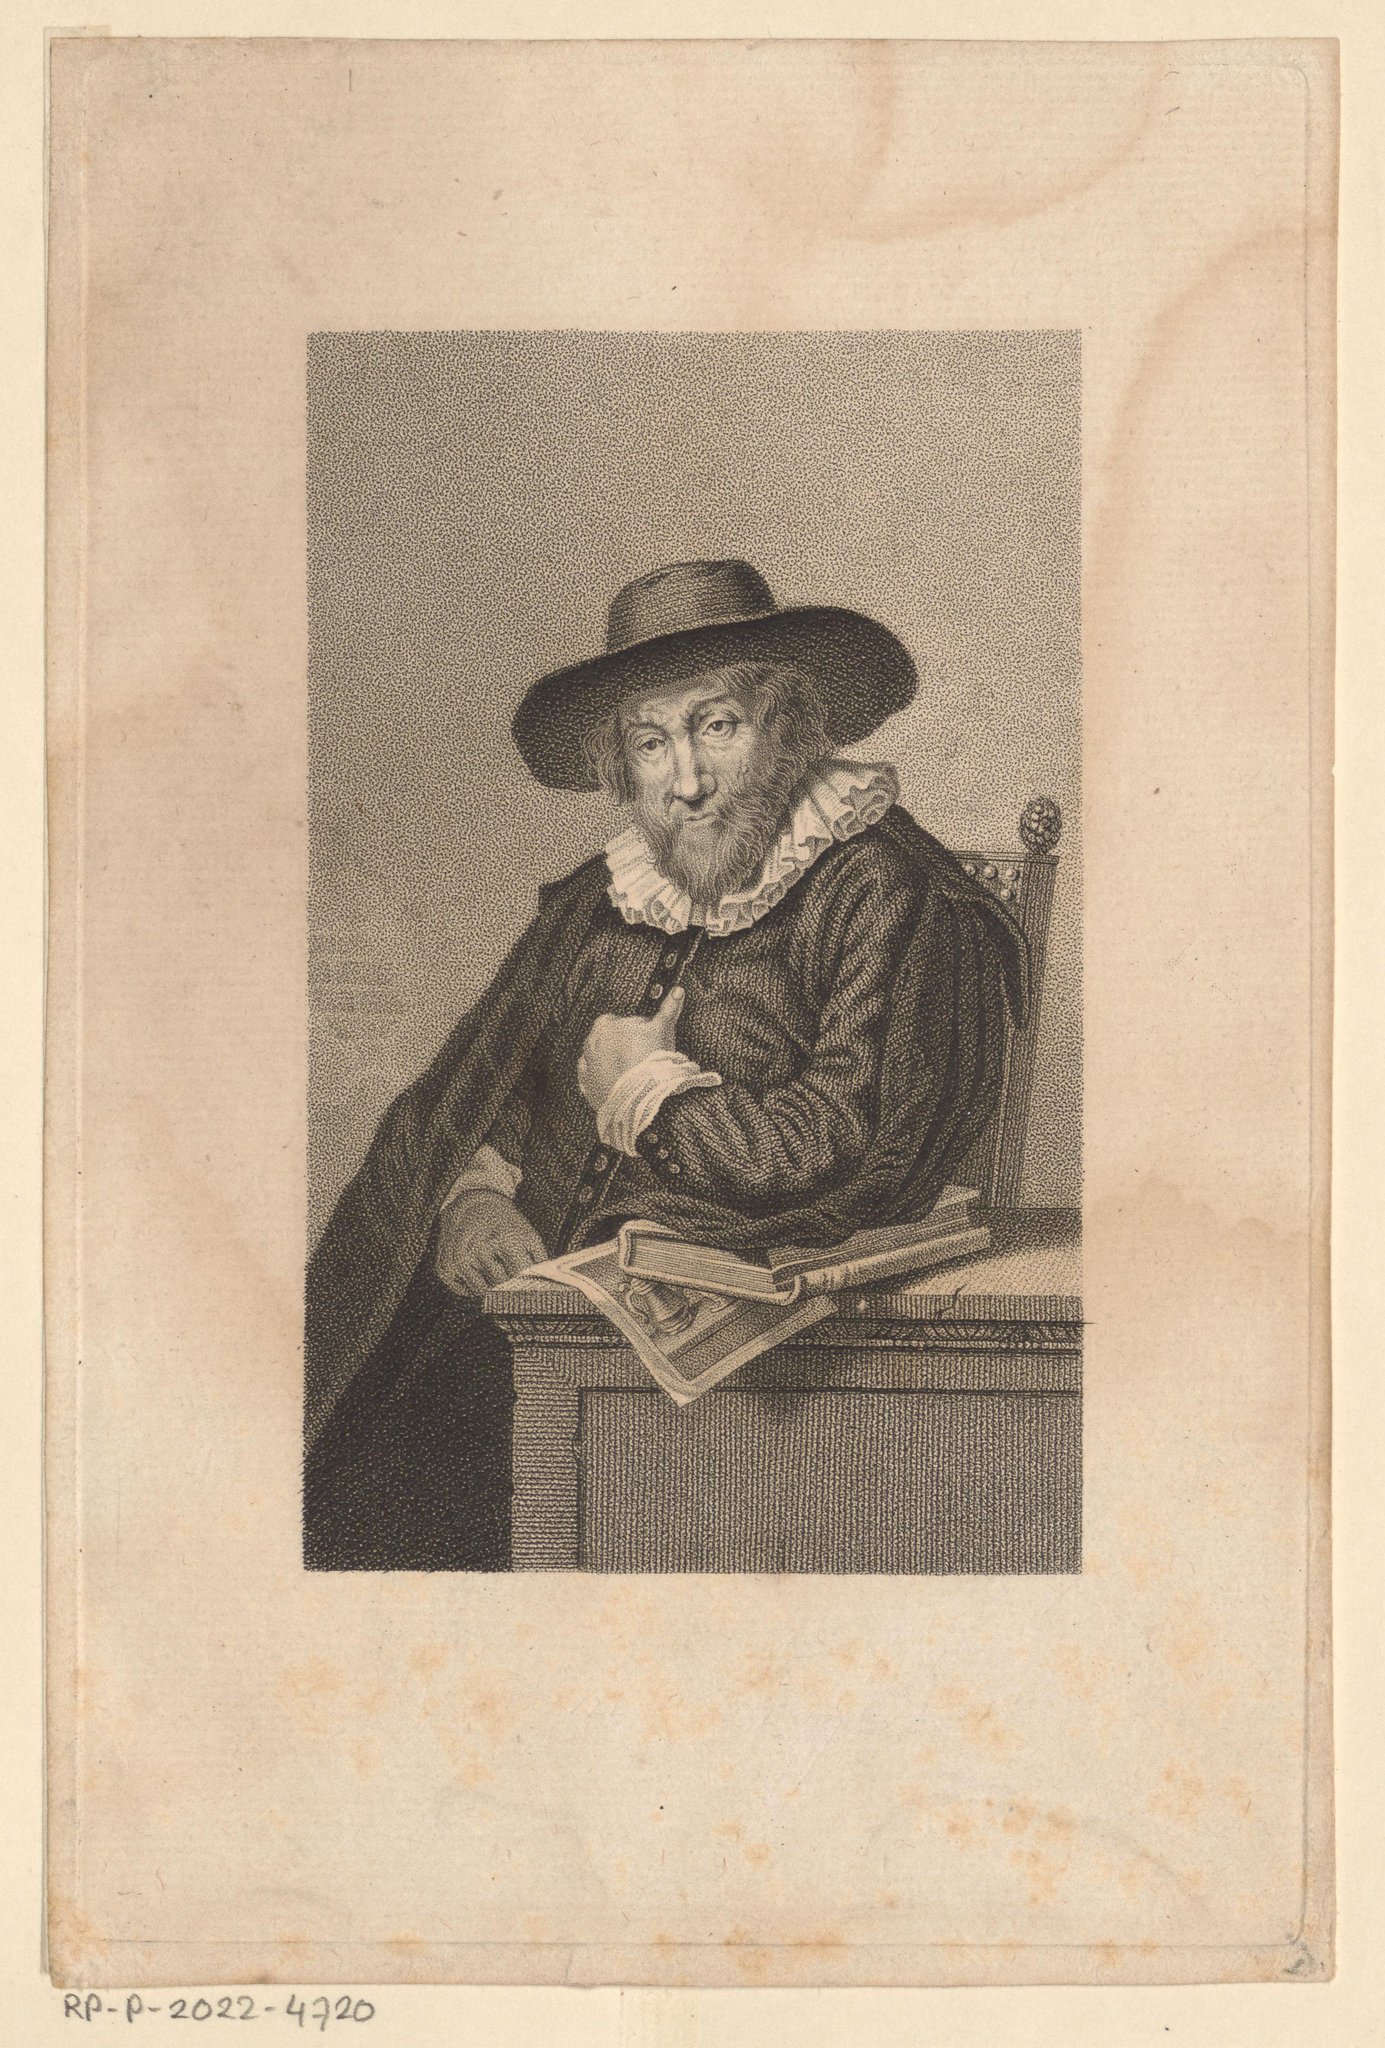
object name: print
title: Portret van Roemer Visscher op 71-jarige leeftijd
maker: pieter van der meulen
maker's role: draughtsman, painter, print maker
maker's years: 1780-1858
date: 1808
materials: paper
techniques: etching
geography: northern netherlands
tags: roemer visscher, historical persons, portrait of a writer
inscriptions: collector's mark: Lugt 2228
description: Latere staat gebruikt in: Scheltema, Jacobus. Anna en Maria Tesselschade, de dochters van Roemer Visscher. Amsterdam: J.W. Ijntema en Comp., 1808.